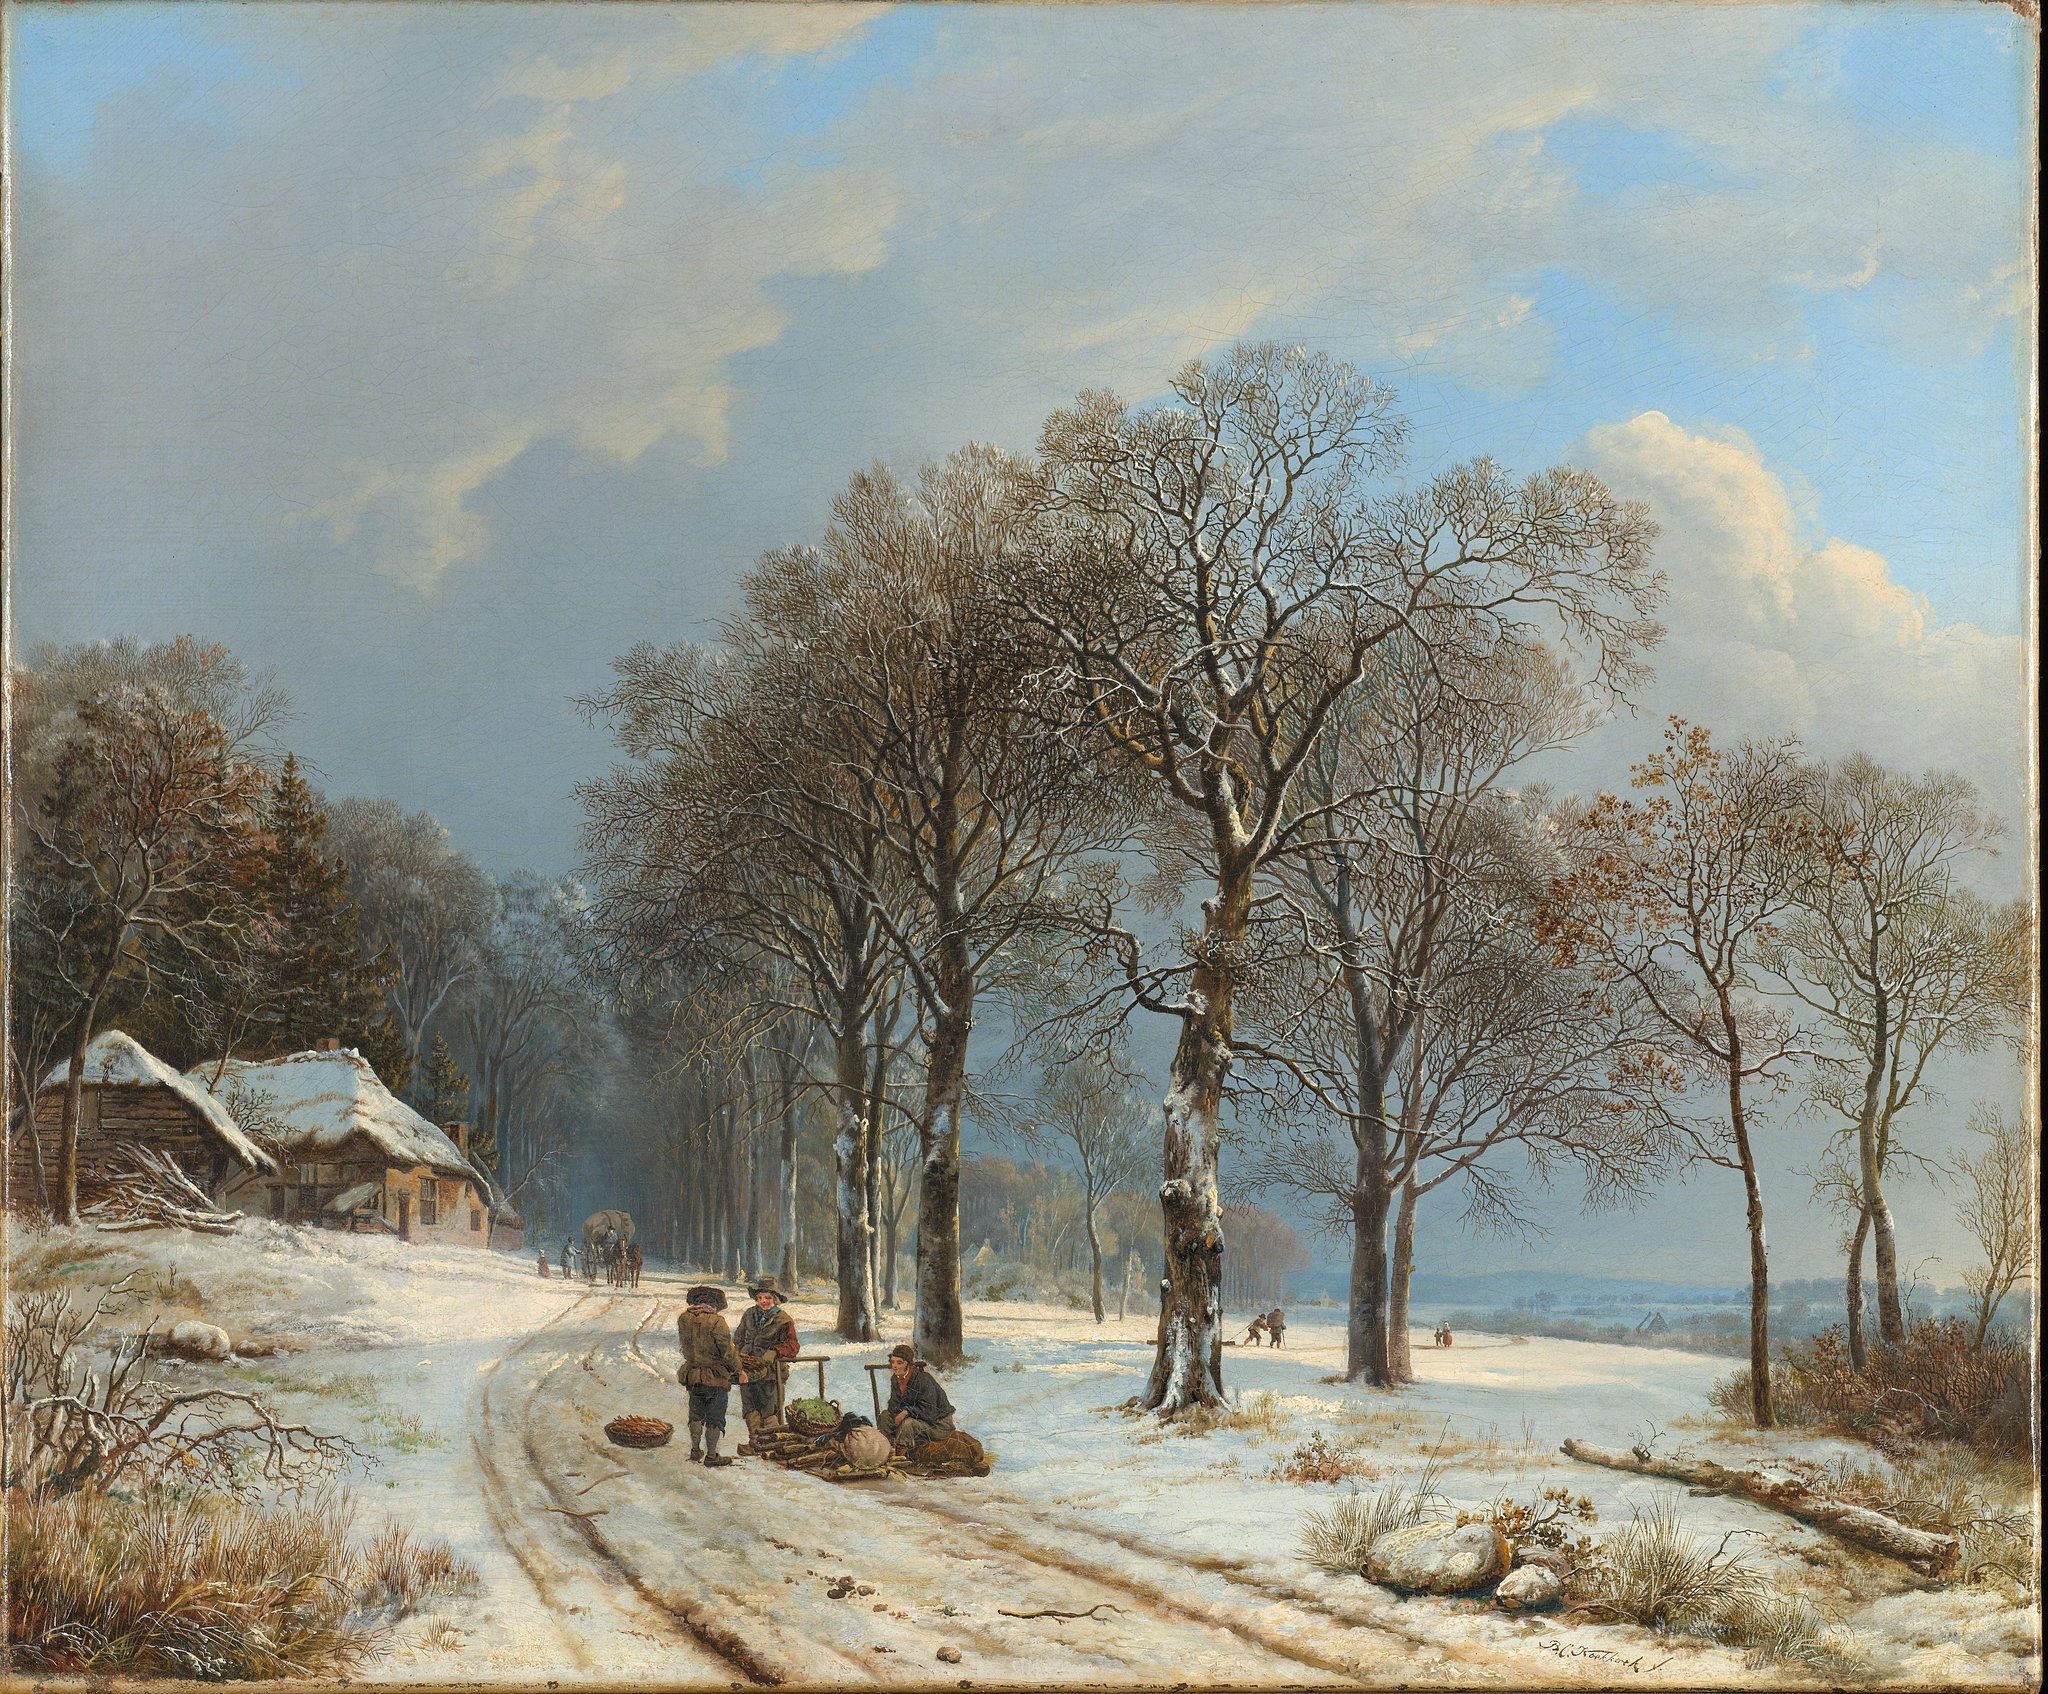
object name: painting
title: Winter Landscape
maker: barend cornelis koekkoek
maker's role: draughtsman, painter, print maker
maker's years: 1803-1862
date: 1835-1838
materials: canvas, oil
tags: sleigh, sledge (non-sport), winter landscape; landscape symbolizing winter (the four seasons of the year), snow, farm or solitary house in landscape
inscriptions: signature: ‘B.C. Koekkoek f’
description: For this winter landscape, Koekkoek chose a hilly region in Gelderland or the German region of the Lower Rhine. Unlike his imposing forest views, this is a peaceful scene, with men pausing beside a sled laden with brushwood and vegetables. A panorama stretches out through the mist in the distance. The painting shows tranquil view of nature on a winter’s day, a world blanketed in a layer of pristine snow.